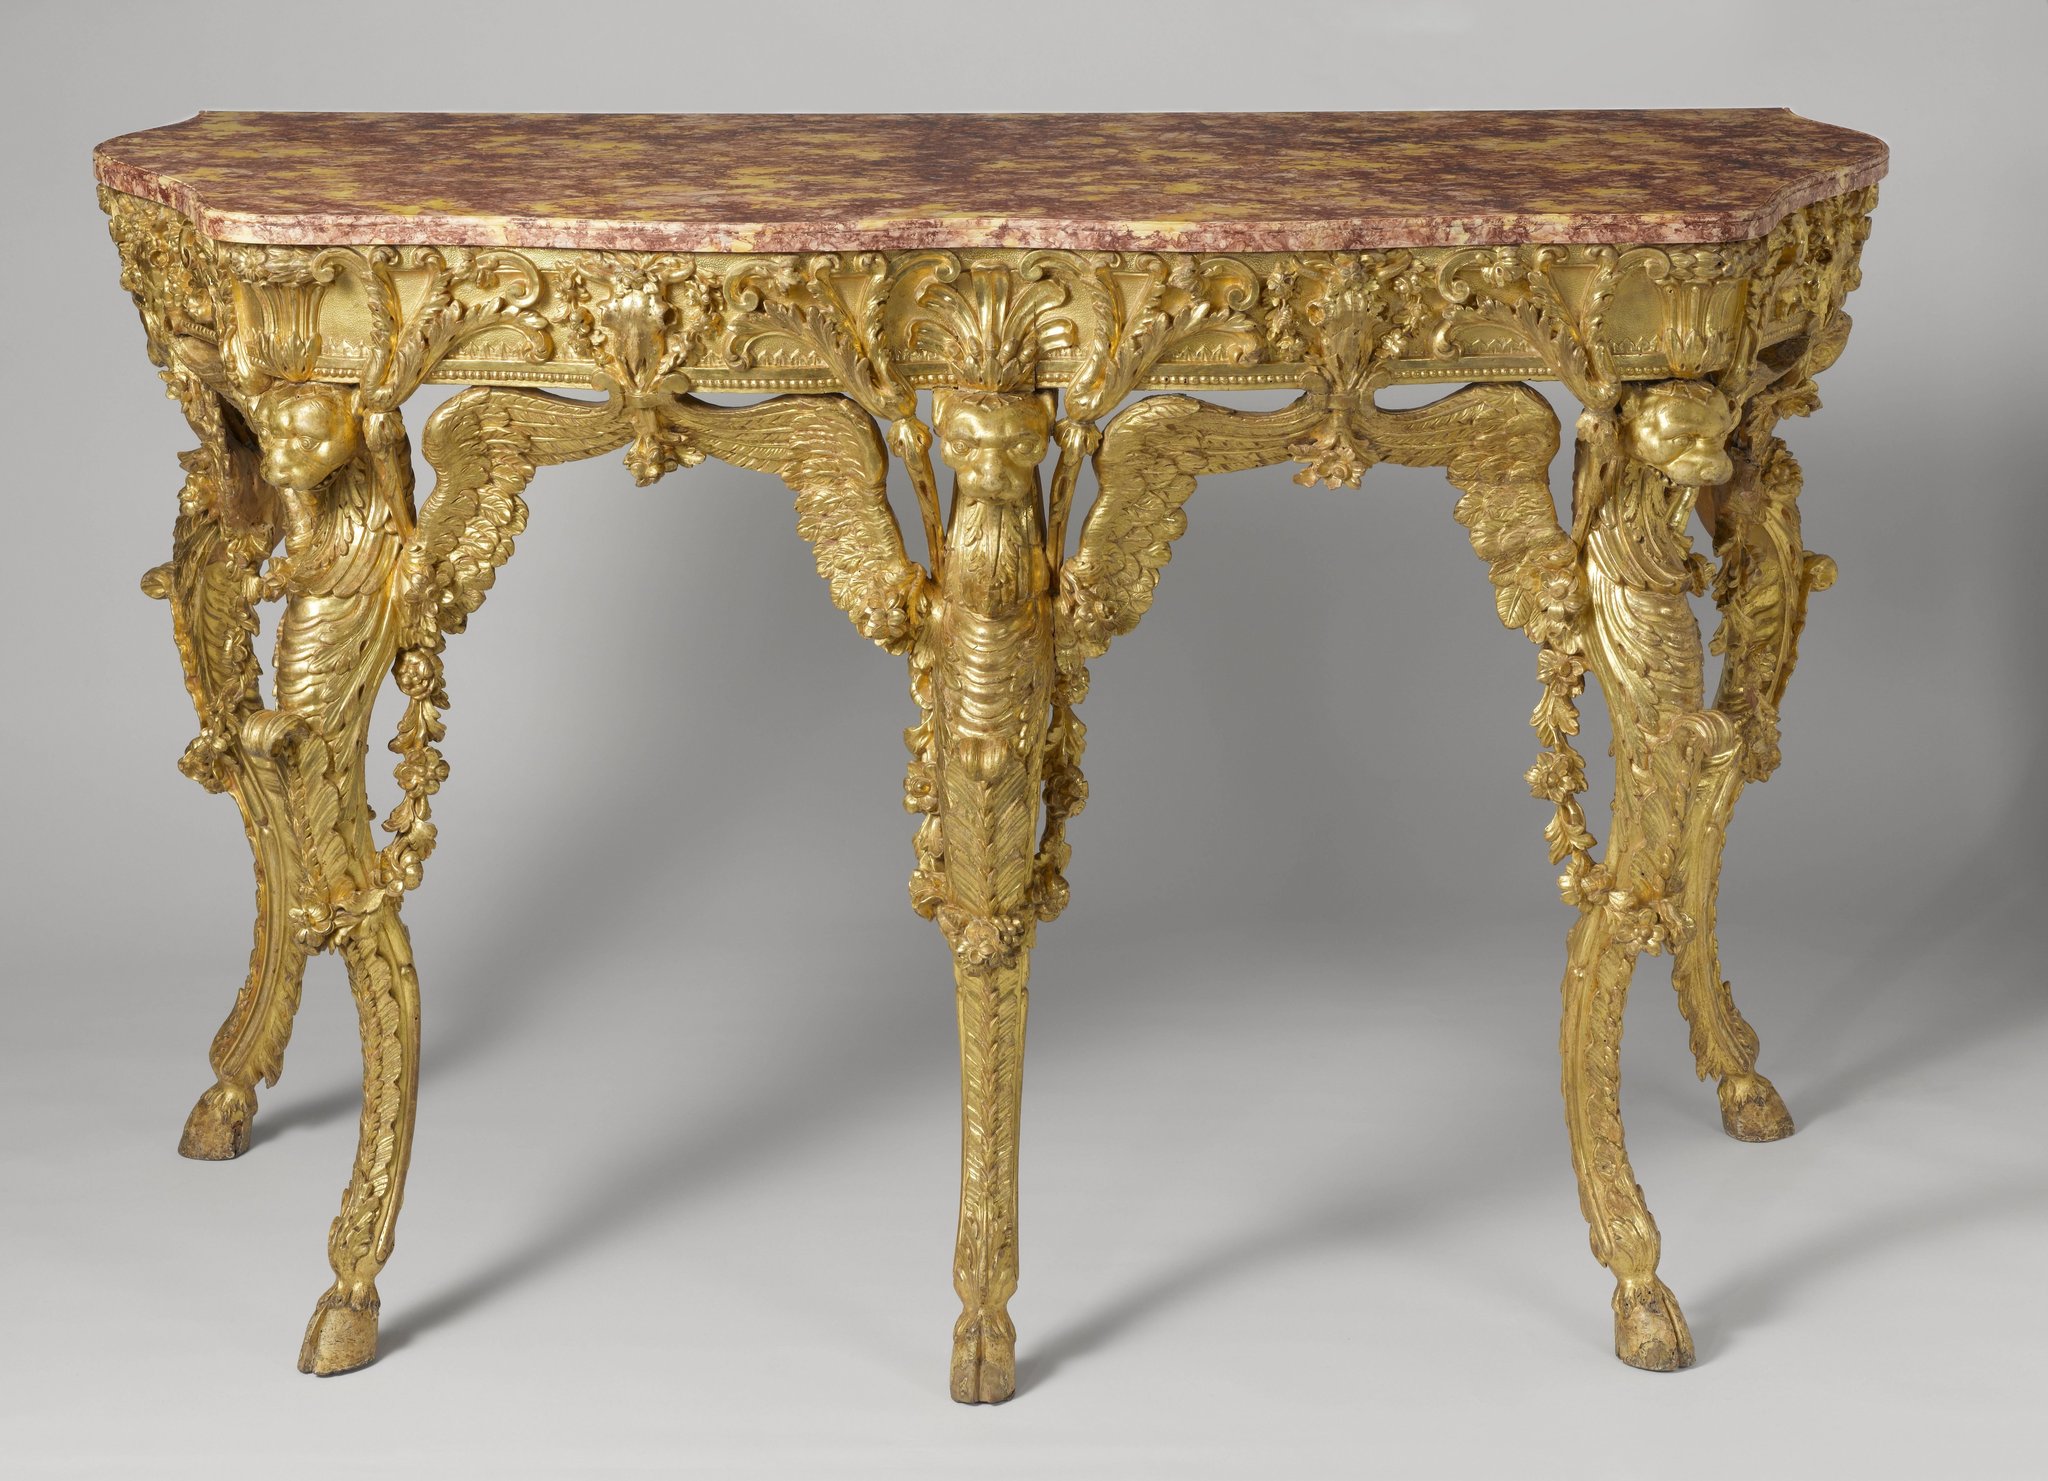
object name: wandtafel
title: Console table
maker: Anonymous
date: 1769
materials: wood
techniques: gilding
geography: rome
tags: ornament ~ hybrid animals, acanthus ~ ornament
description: This console table is the only piece of furniture known with certainty to have been designed by Piranesi. With its bizarre legs shaped like imaginary winged animals, this table is an example of Piranesi’s idiosyncratic, highly personal contribution to the development of a new classicizing style. It was made, along with a second matching table, for the Italian cardinal Giovanni Battista Rezzonico.